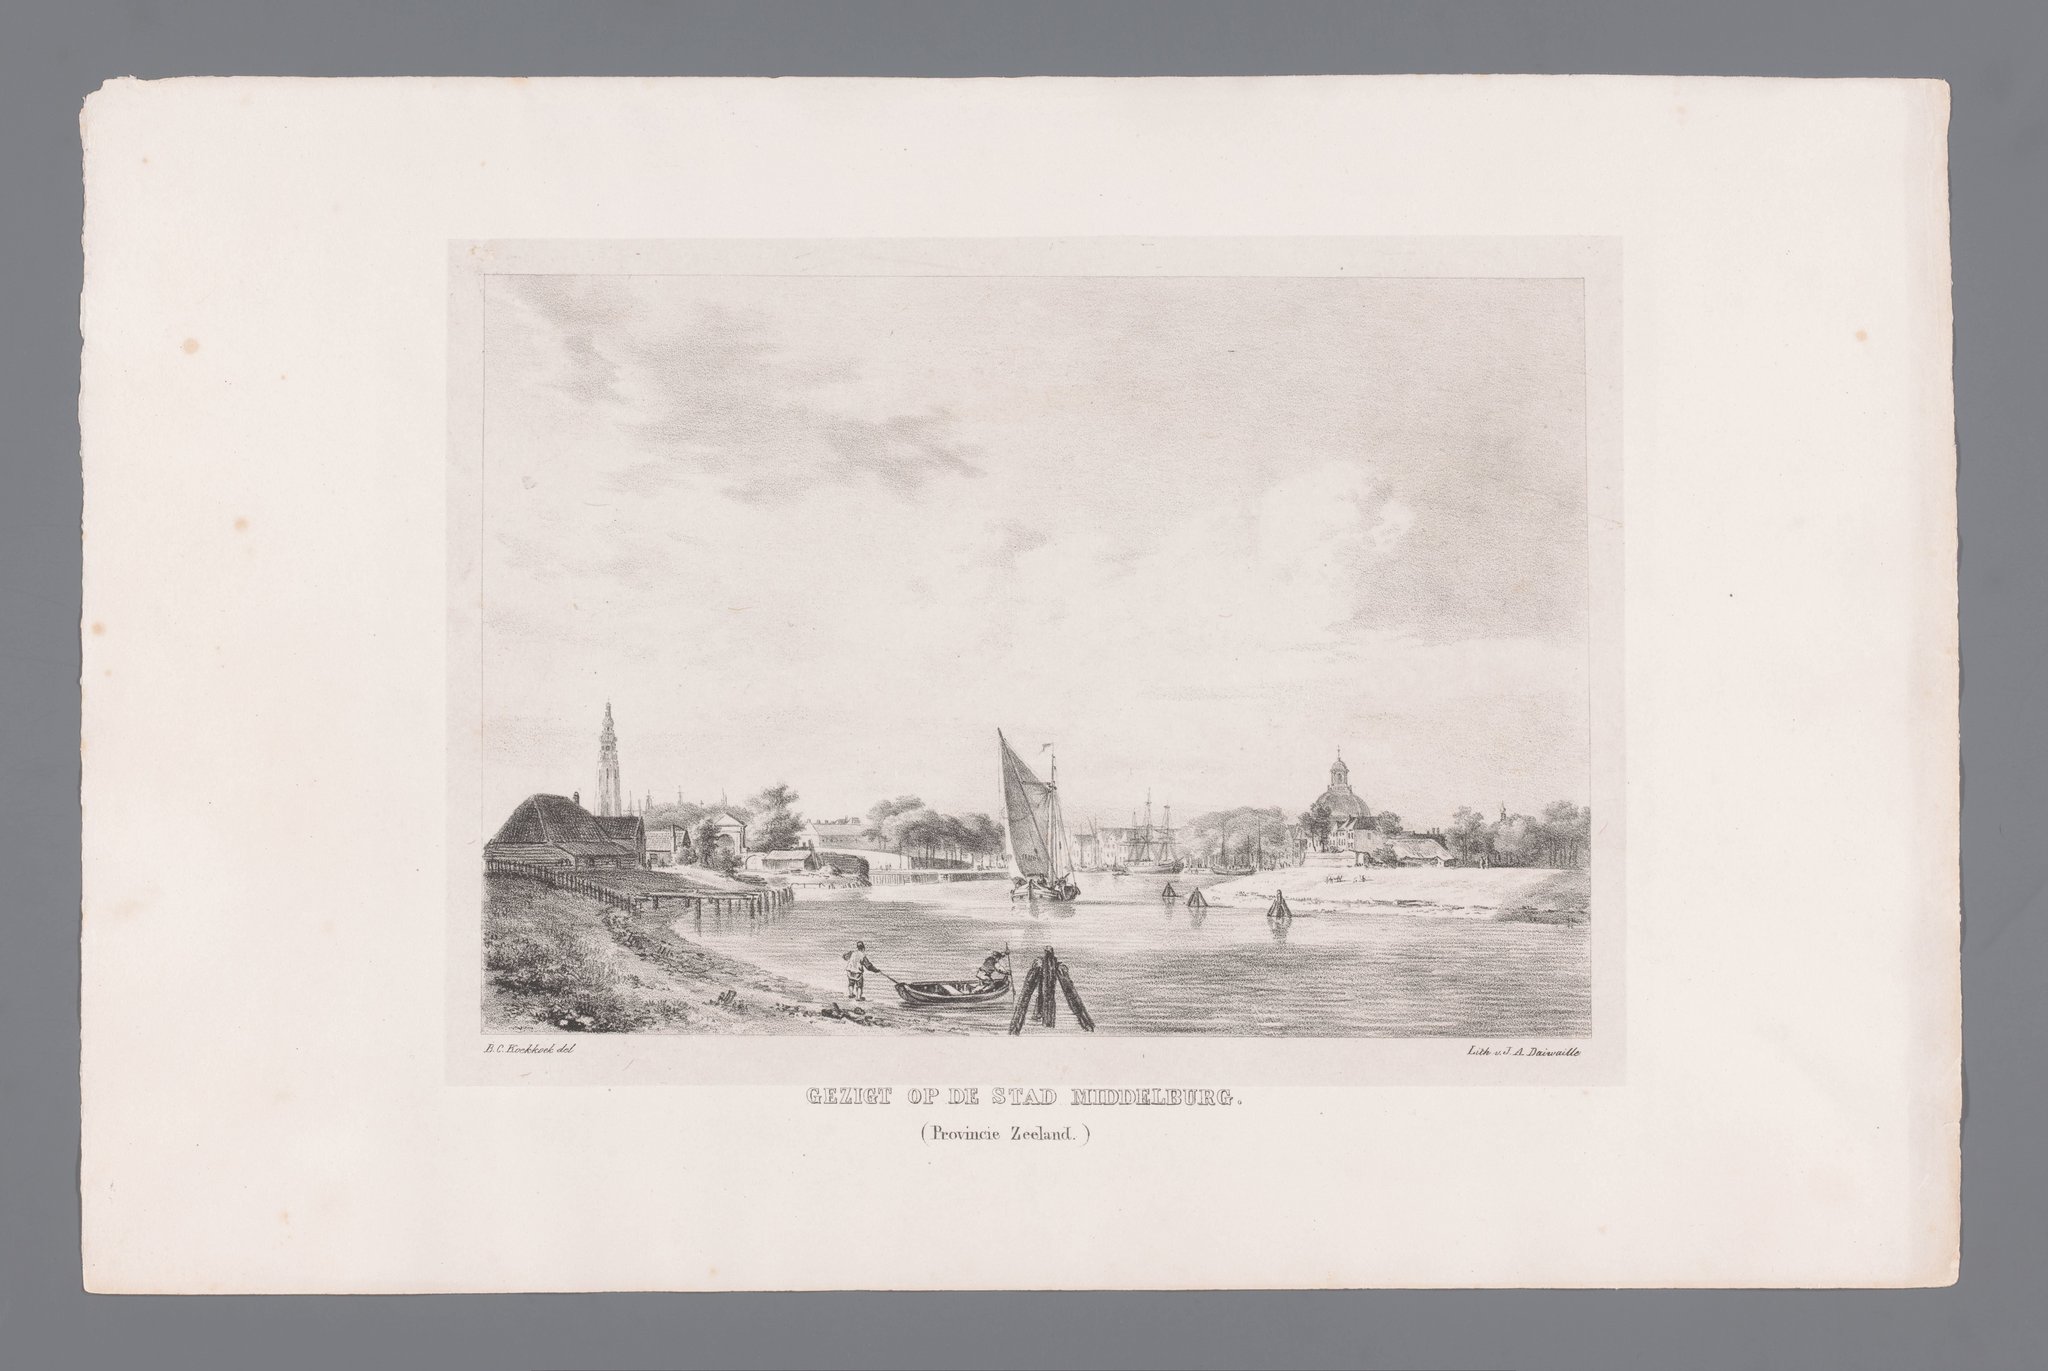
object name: print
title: Gezicht op Middelburg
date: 1831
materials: paper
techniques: lithograph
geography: amsterdam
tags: city-view, and landscape with man-made constructions, sailing-ship, sailing-boat, rowing-boat, canoe, etc., middelburg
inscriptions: collector's mark: Lugt 2228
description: Een roeiboot wordt naar de kant gehaald, op het water vaart een zeilschip. Links de toren van de Nieuwe Kerk, rechts de koepel van de Oostkerk. Deze prent maakt deel uit van een omslag met negen prenten.